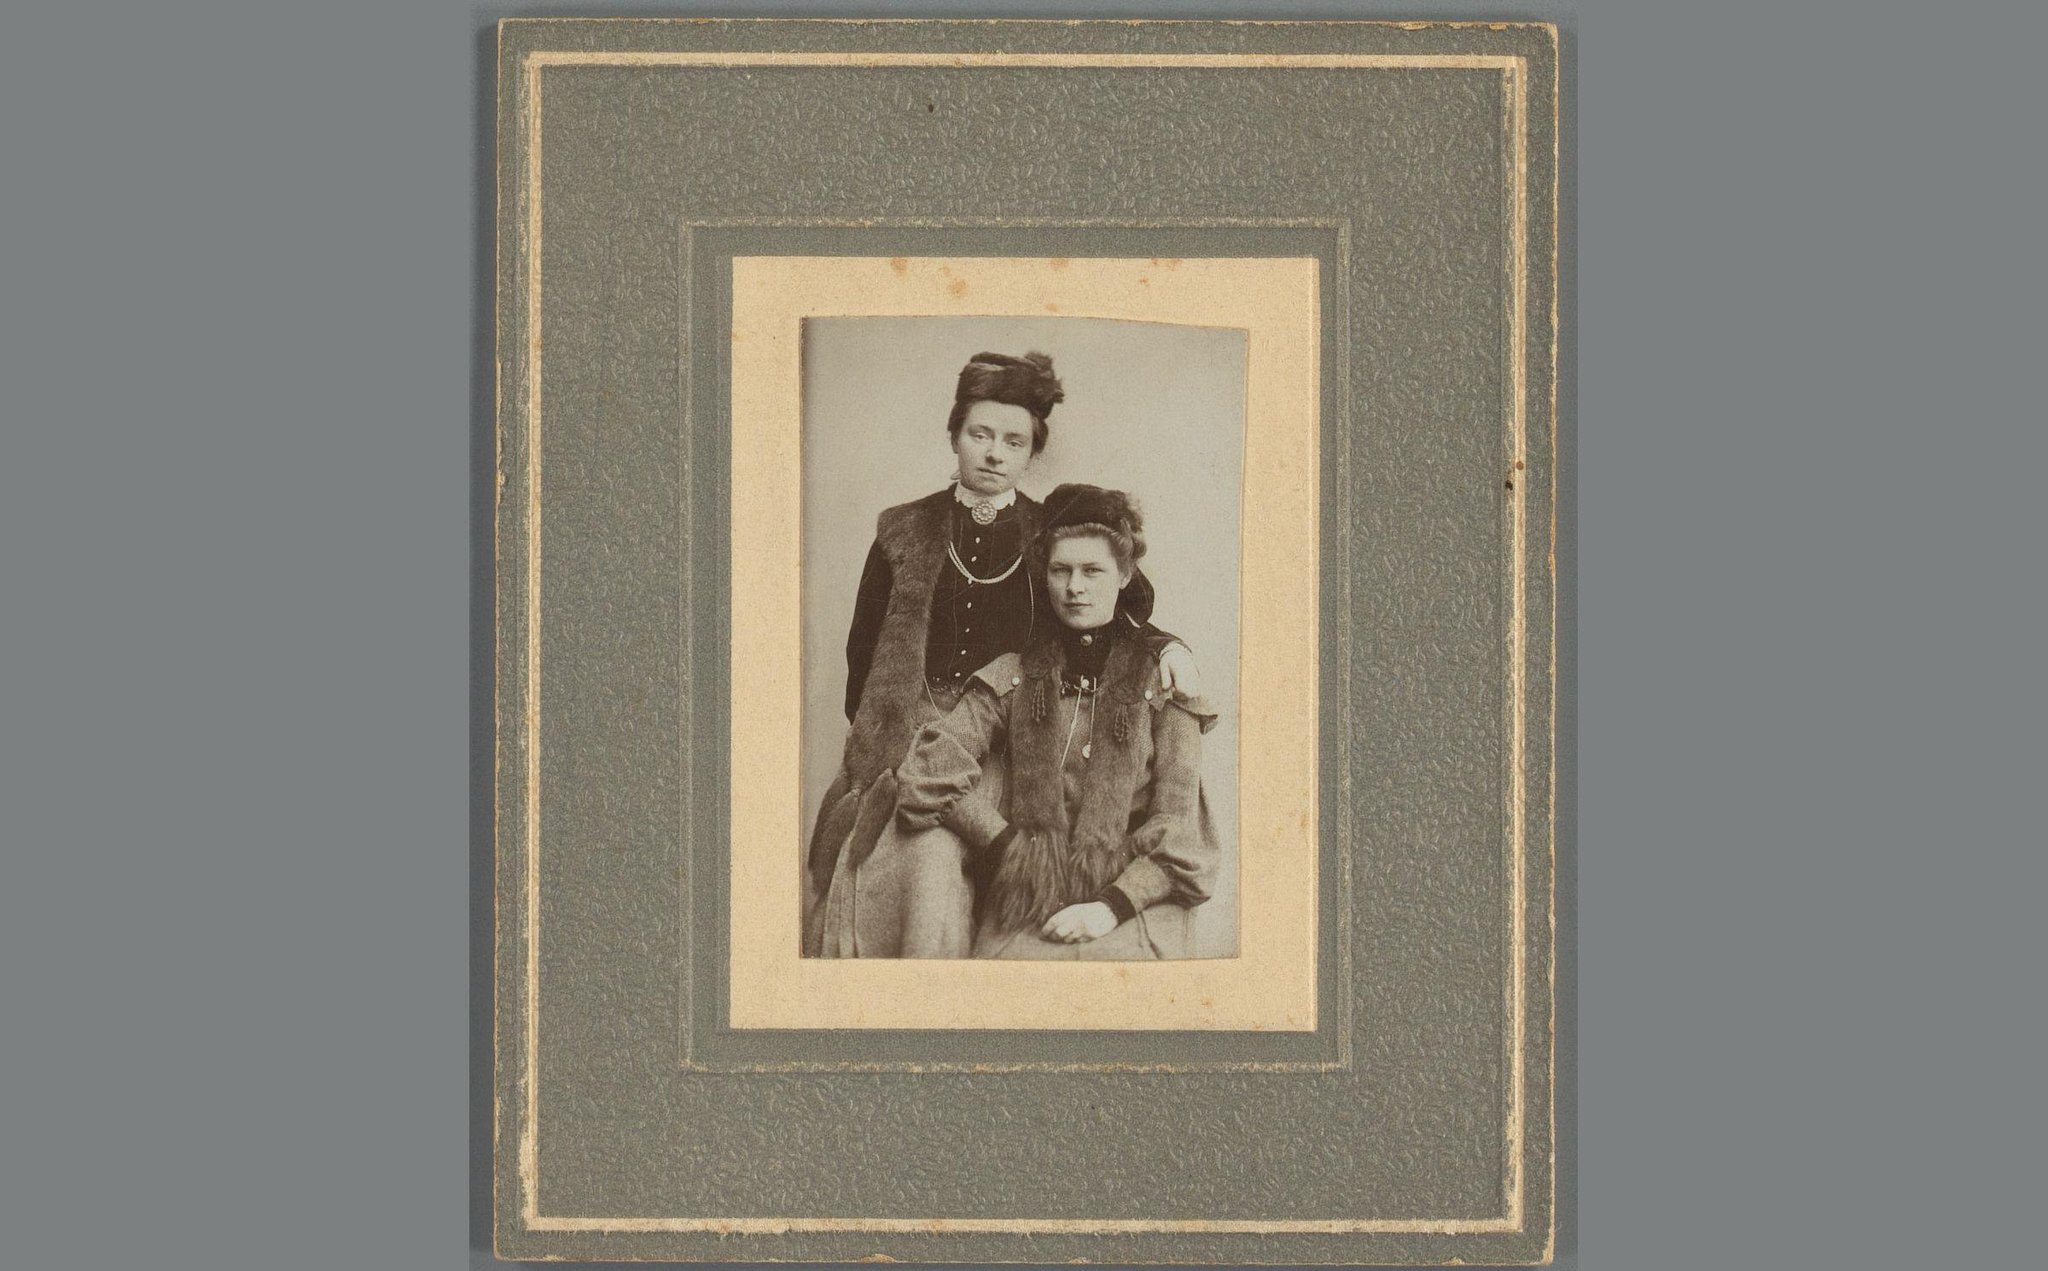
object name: photograph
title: Dubbelportret van twee onbekende jonge vrouwen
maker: Anonymous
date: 1880-1910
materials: paper, cardboard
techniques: collodion silver print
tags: adult woman, historical persons not known by name - bb - woman, hand on shoulder (friends)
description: Een van de vrouwen is de geportretteerde van RP-F-F15659.